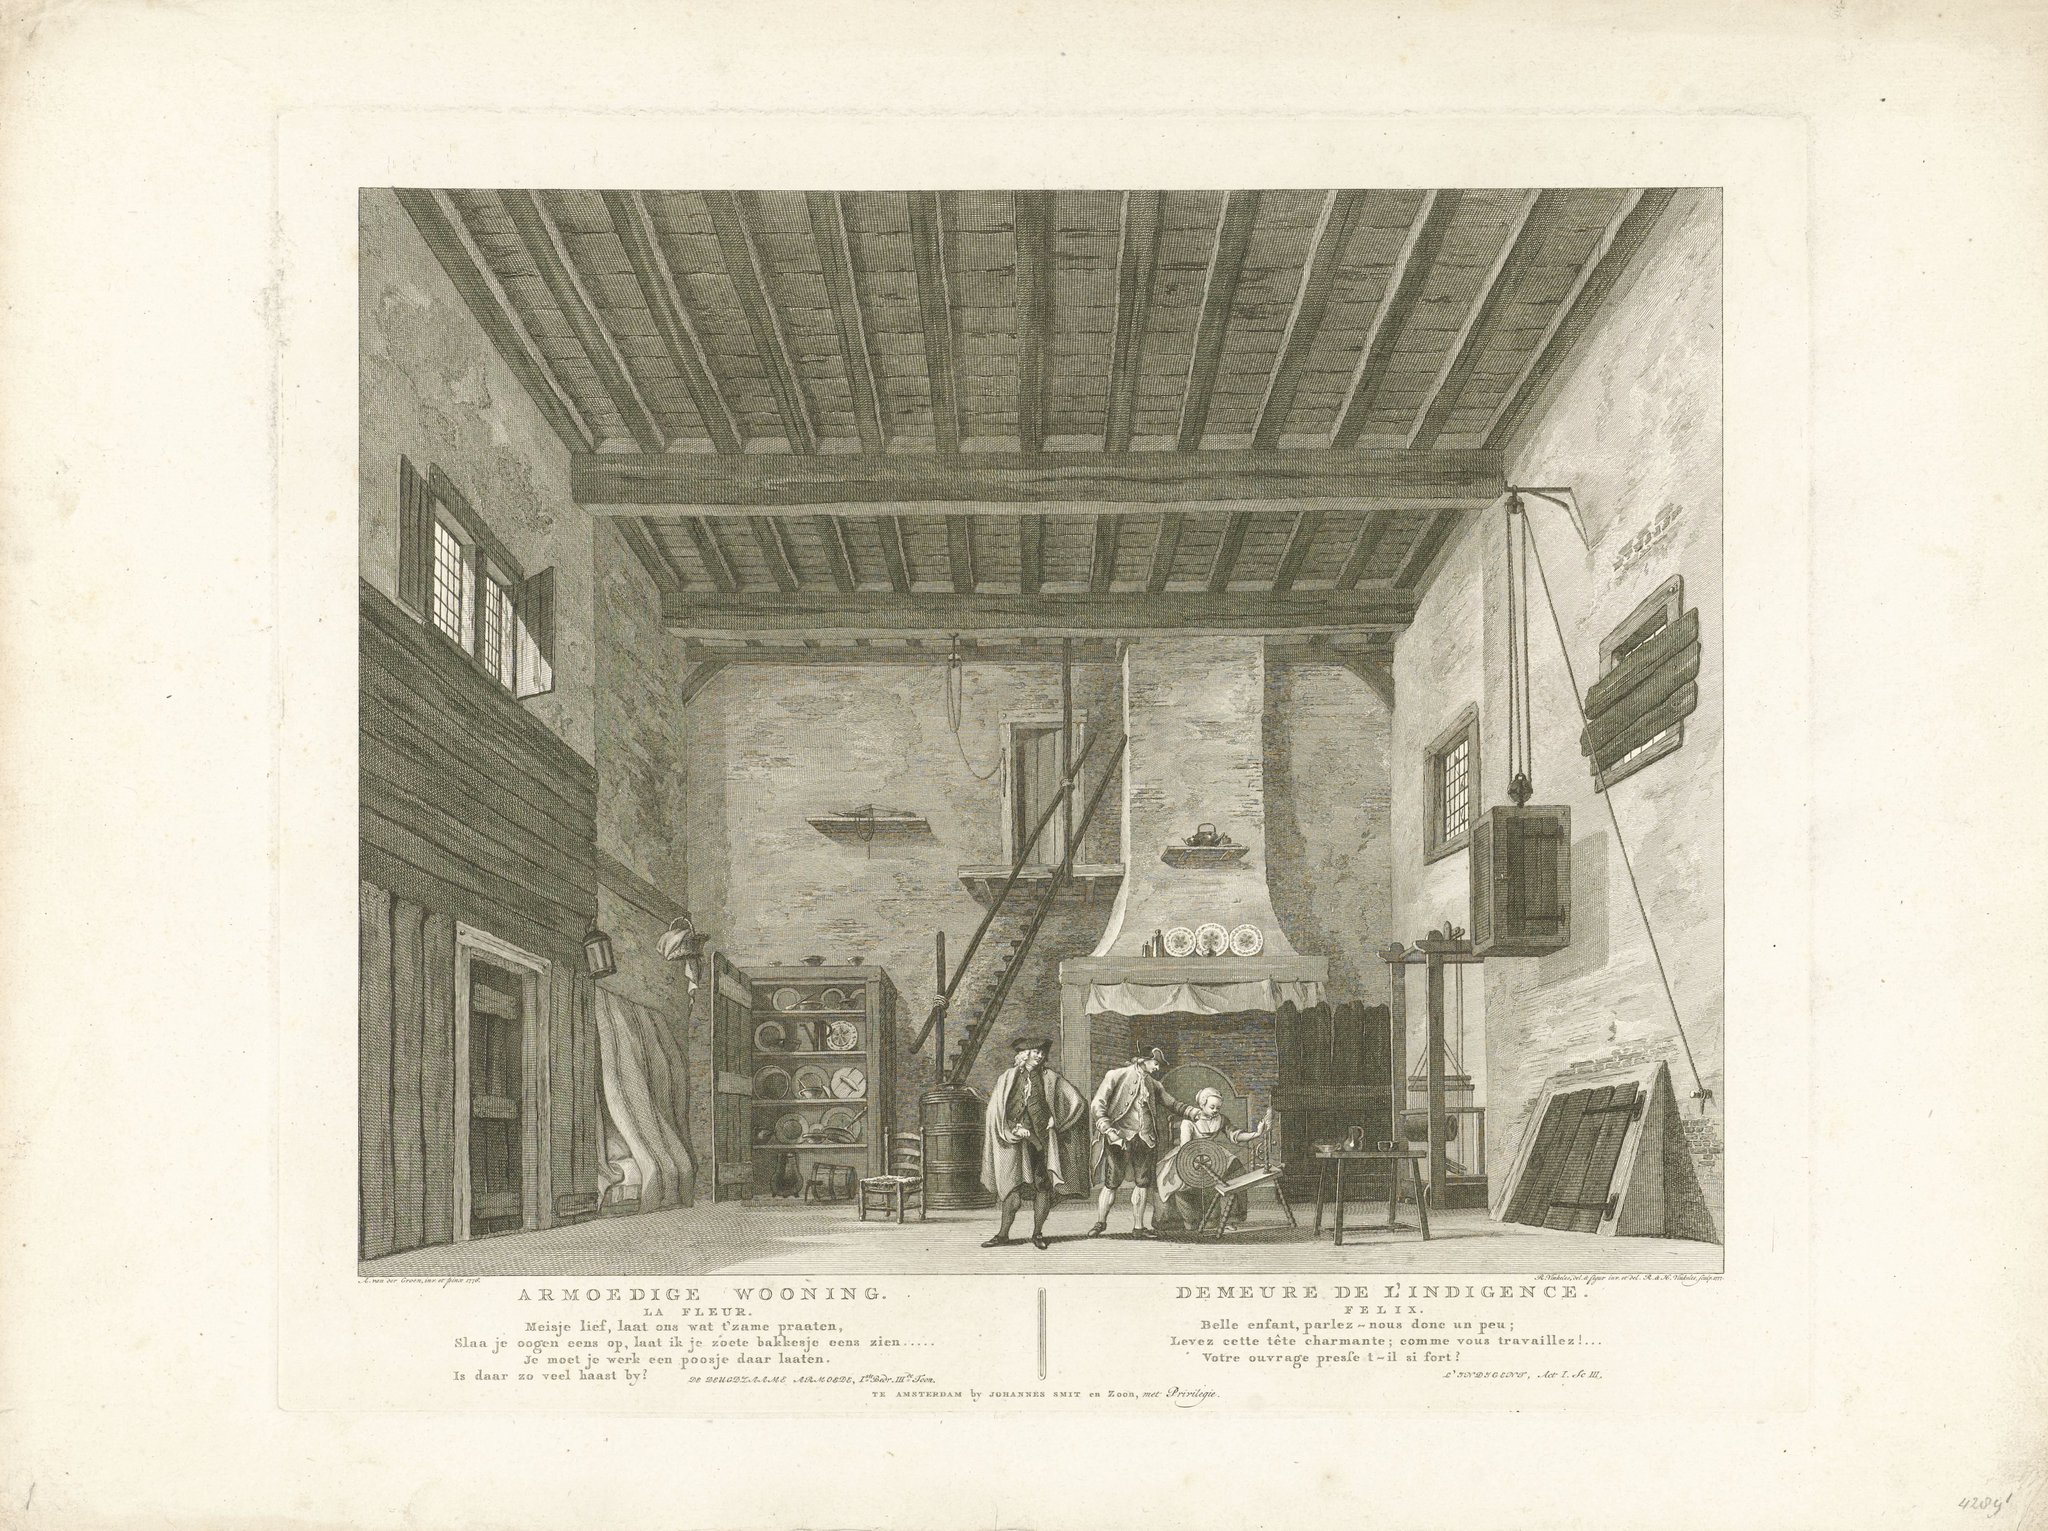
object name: print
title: Toneeldecors van de nieuwe Amsterdamse Schouwburg, 1775-1777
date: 1777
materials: paper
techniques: engraving, etching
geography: northern netherlands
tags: stage design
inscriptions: collector's mark: Lugt 2228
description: Het coulissendecor Armoedige Wooning, met een scène uit: De Deugdzame Armoede. Onderdeel van een serie van zes toneeldecors van toneelstukken opgevoerd in de nieuwe Amsterdamse Schouwburg uit de jaren 1775-1777.